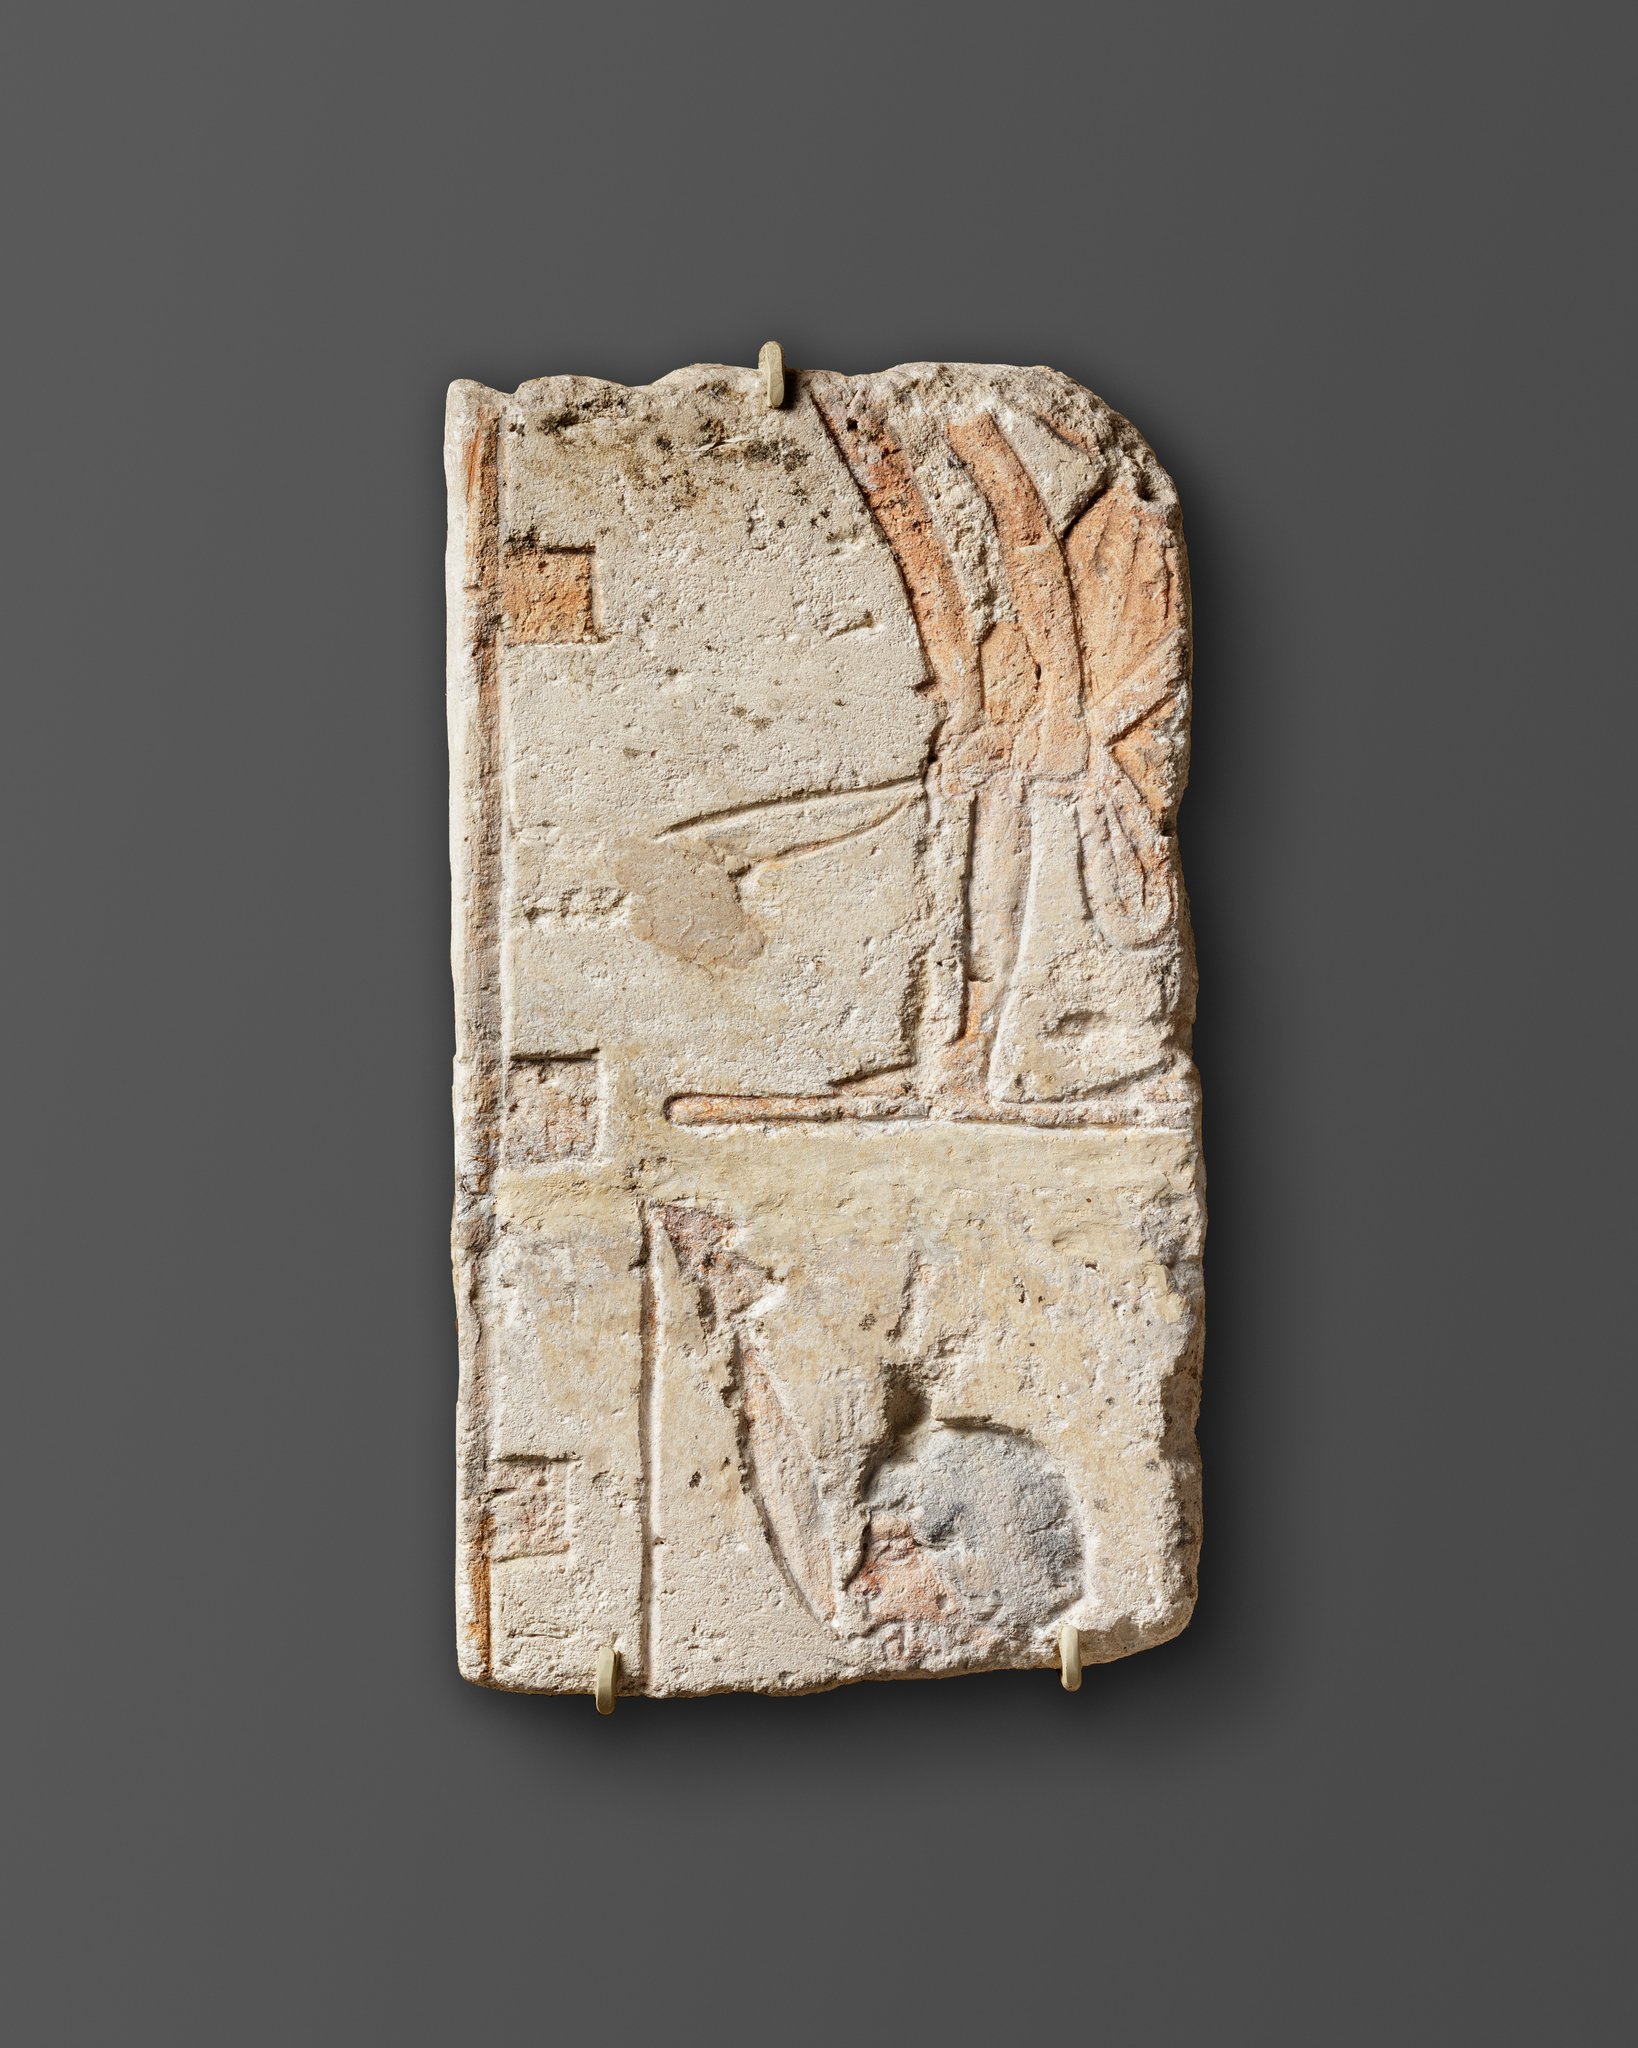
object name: talatat, temple enclosure wall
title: Relief fragment with a temple enclosure wall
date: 1353-1336 BCE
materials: limestone, paint